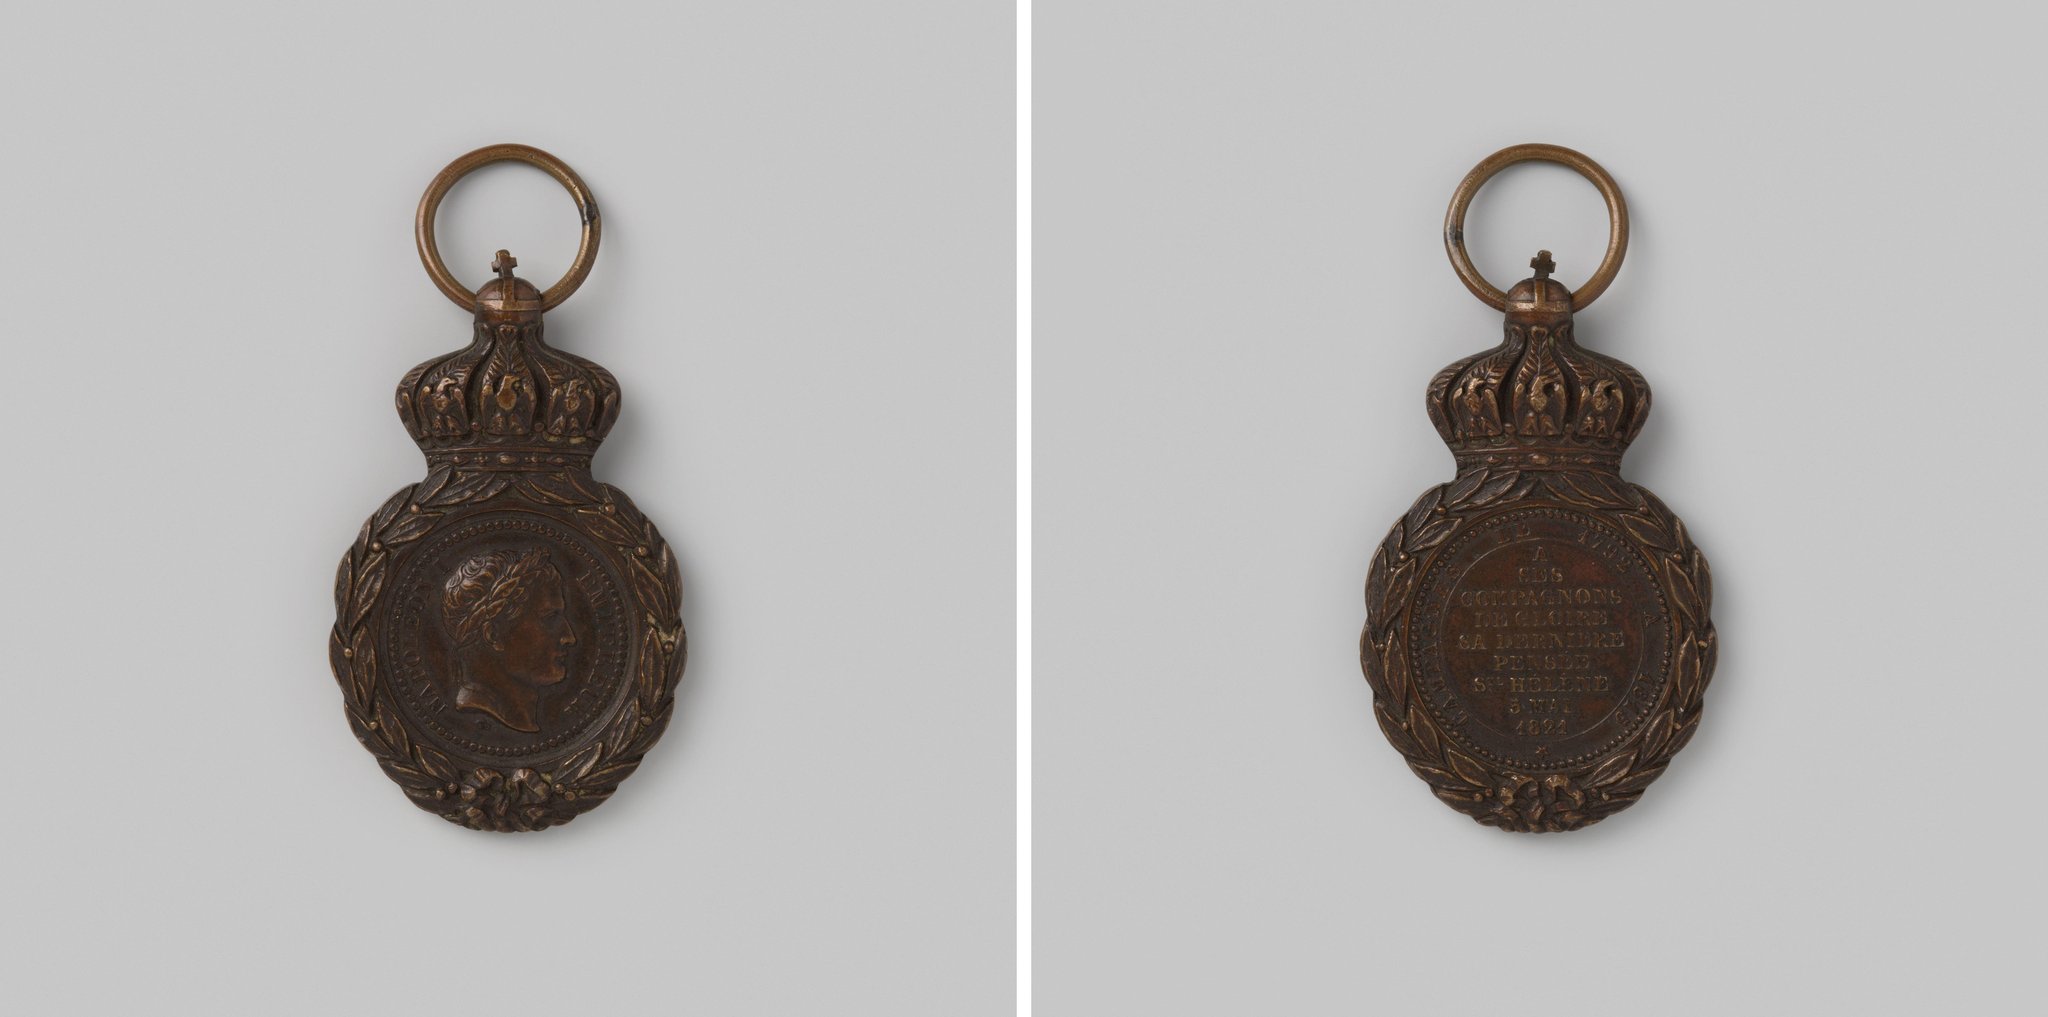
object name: medal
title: Sint-Helenamedaille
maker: désiré-albert barre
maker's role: graficus, medailleur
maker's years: 1818-1878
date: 1857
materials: bronze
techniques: striking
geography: paris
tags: napoleon i (emperor of the french)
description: Bronzen penning in vorm van medaillon, omgeven door lauwerkrans onder kroon met draagring. Voorzijde: borststuk man (Keizer Napoleon Bonaparte) binnen omschrift en parelrand. Keerzijde: opschrift binnen omschrift en parelrand.